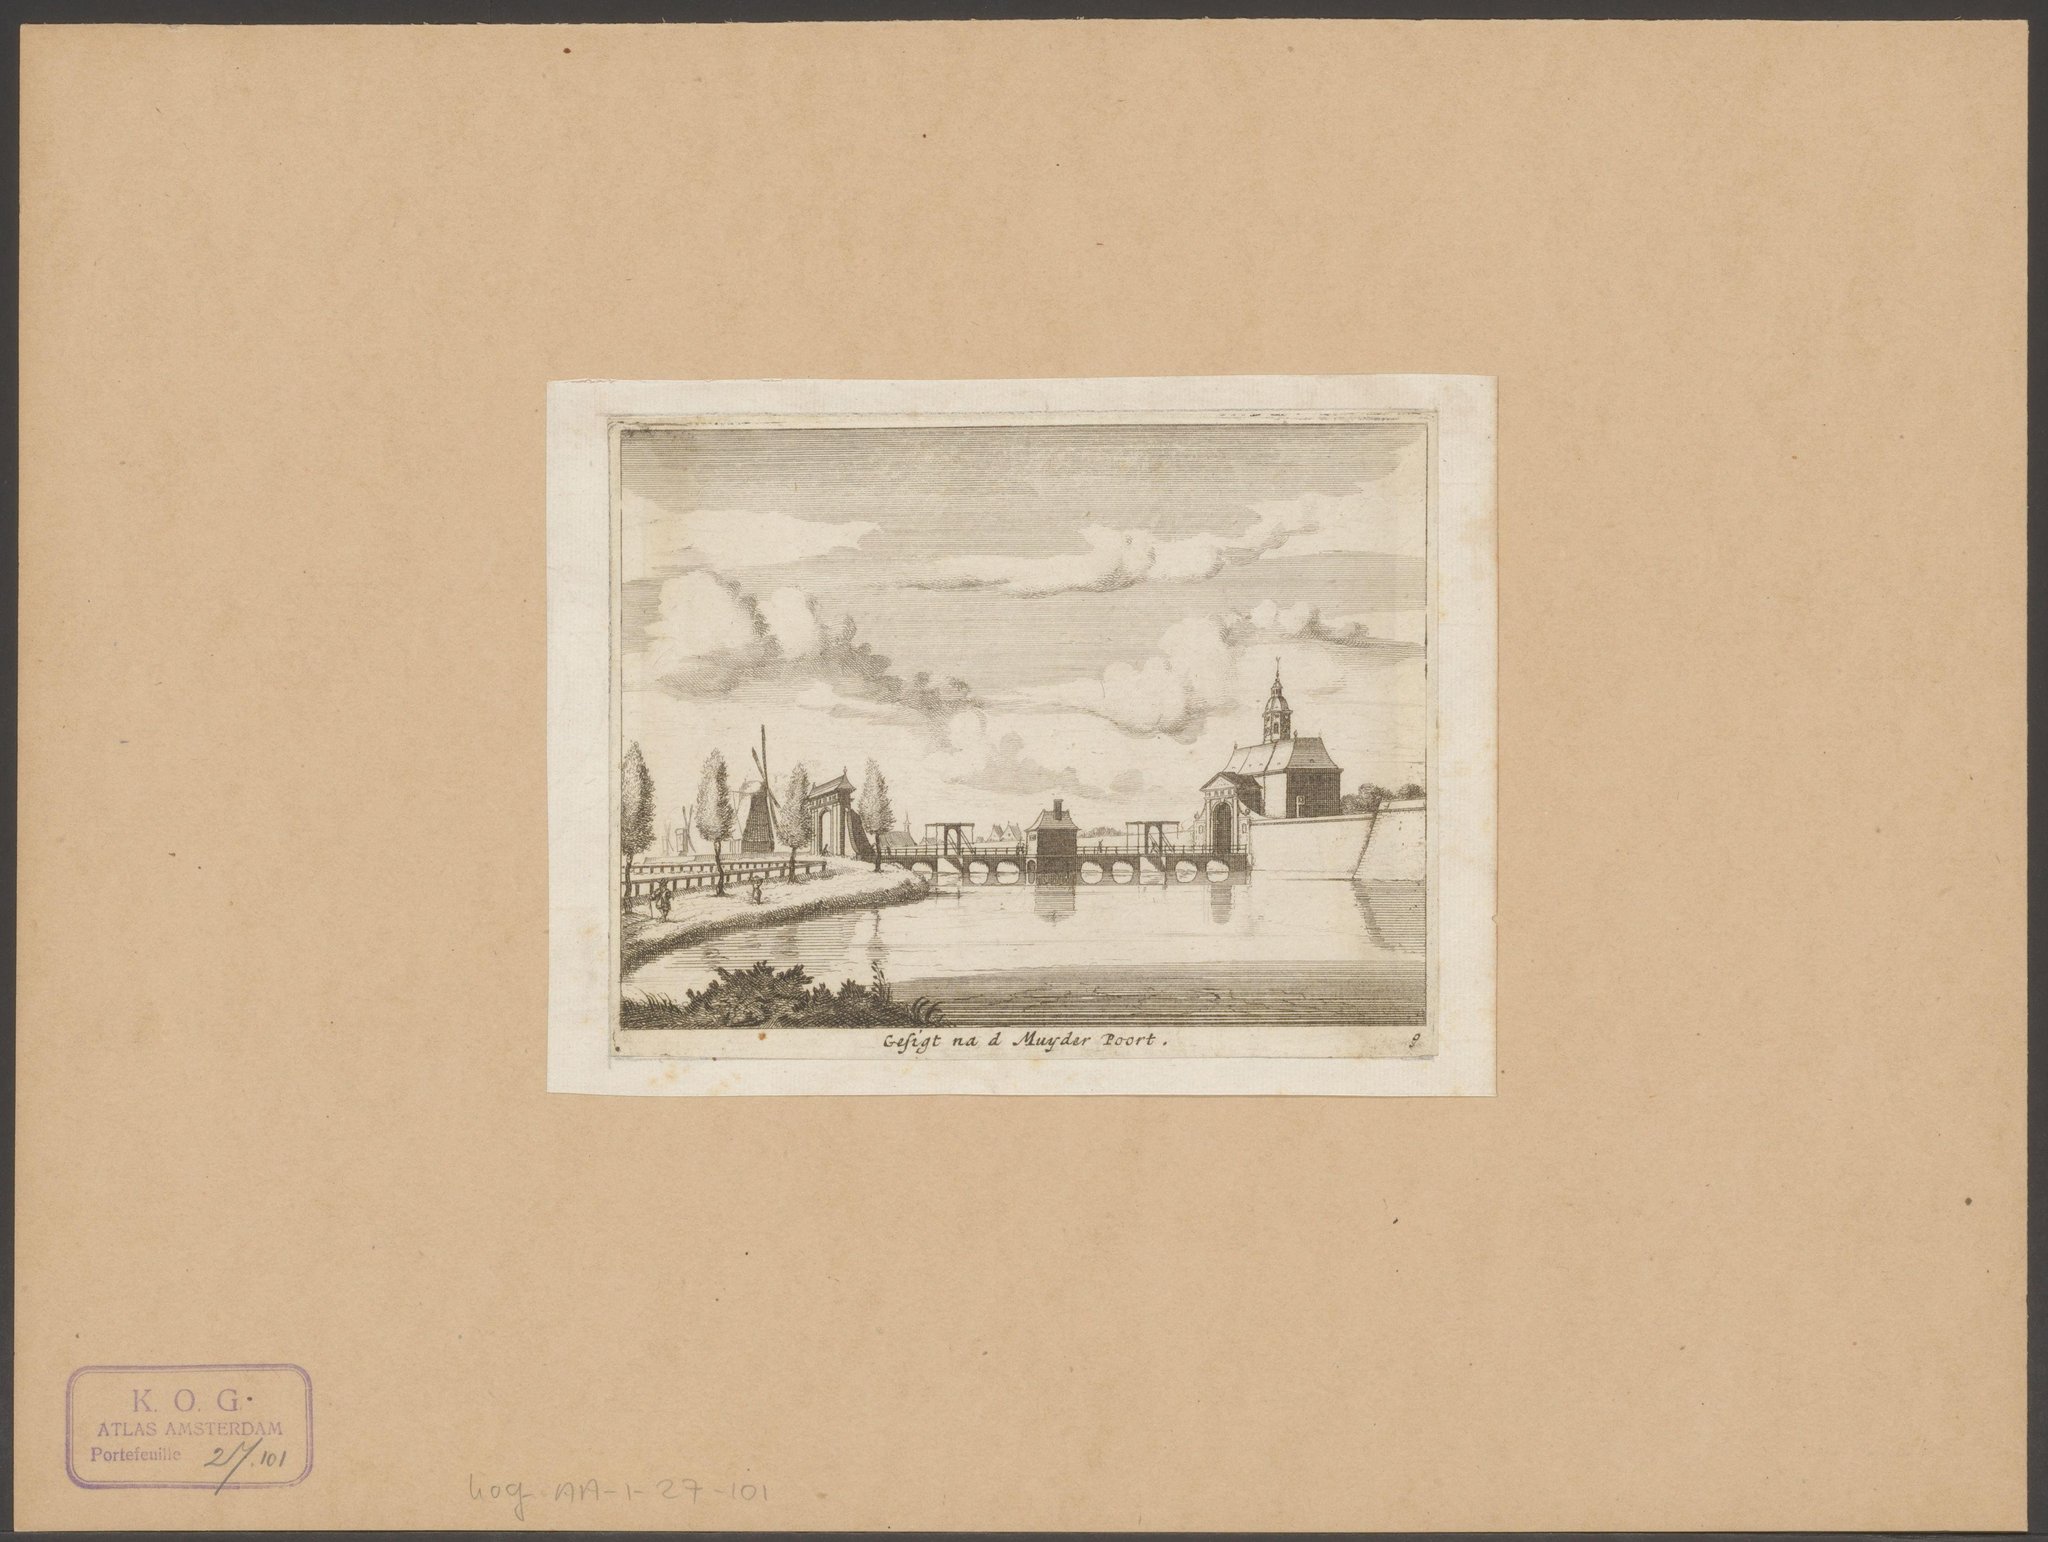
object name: print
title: Gesigt na d Muyder Poort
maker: gerard valck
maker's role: print maker, publisher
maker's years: 1651-1726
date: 1661-1726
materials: paper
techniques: engraving, etching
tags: bridge, city-gate, canal (+ landscape with figures, staffage)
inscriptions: collector's mark: Lugt 1641b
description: Gezicht op de Eerste Muiderpoort en de bijhorende brug te Amsterdam, gezien van buiten de stad. Rechtsonder genummerd: 9. Onderwerpsrubriek binnen de Atlas Amsterdam: B. Poorten, verzamelbladen, G. Eerste Muiderpoort.